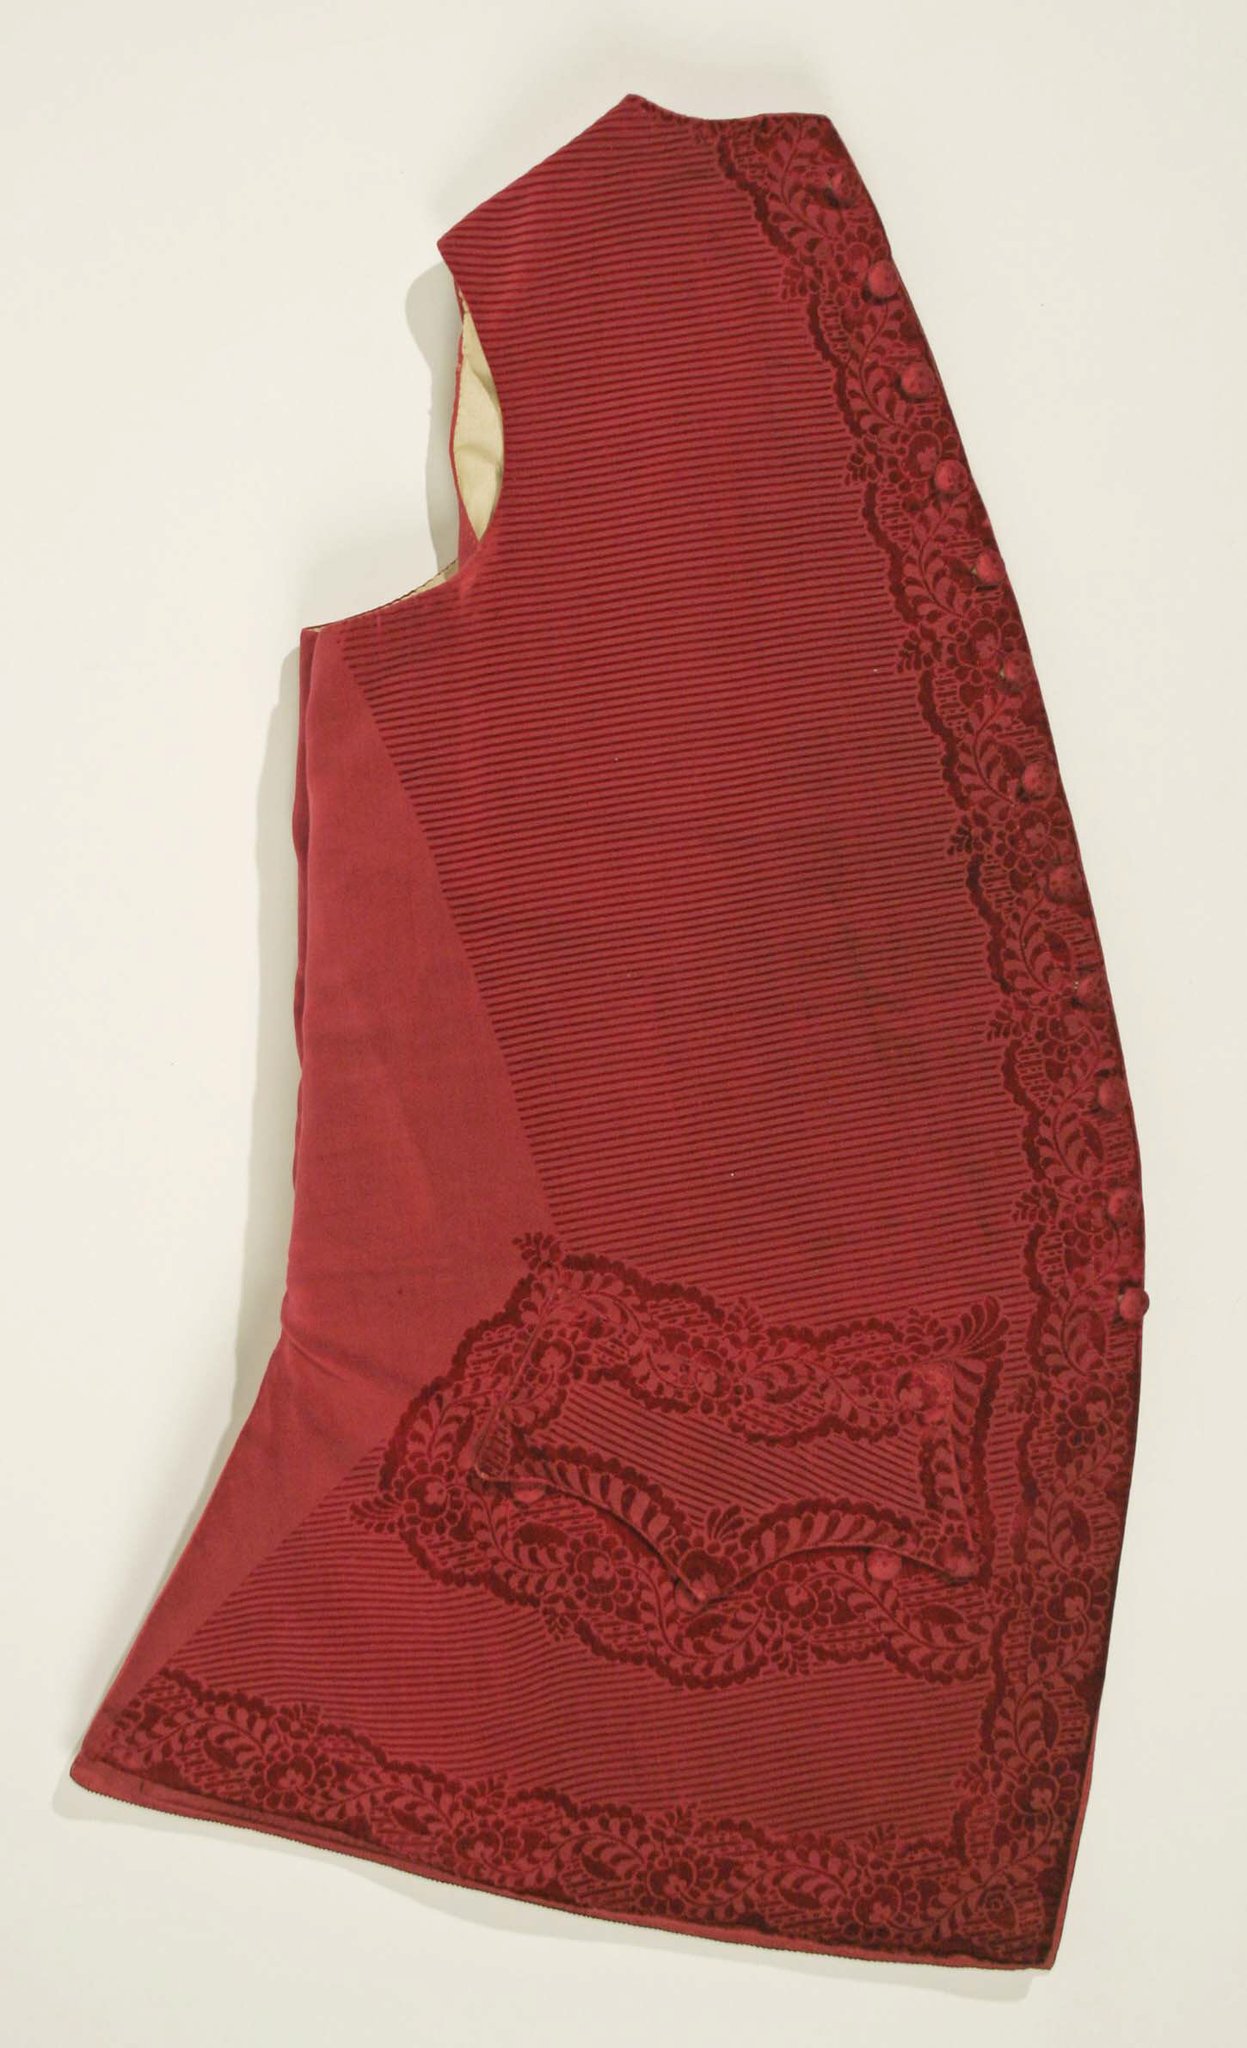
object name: waistcoat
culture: british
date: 1740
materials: silk